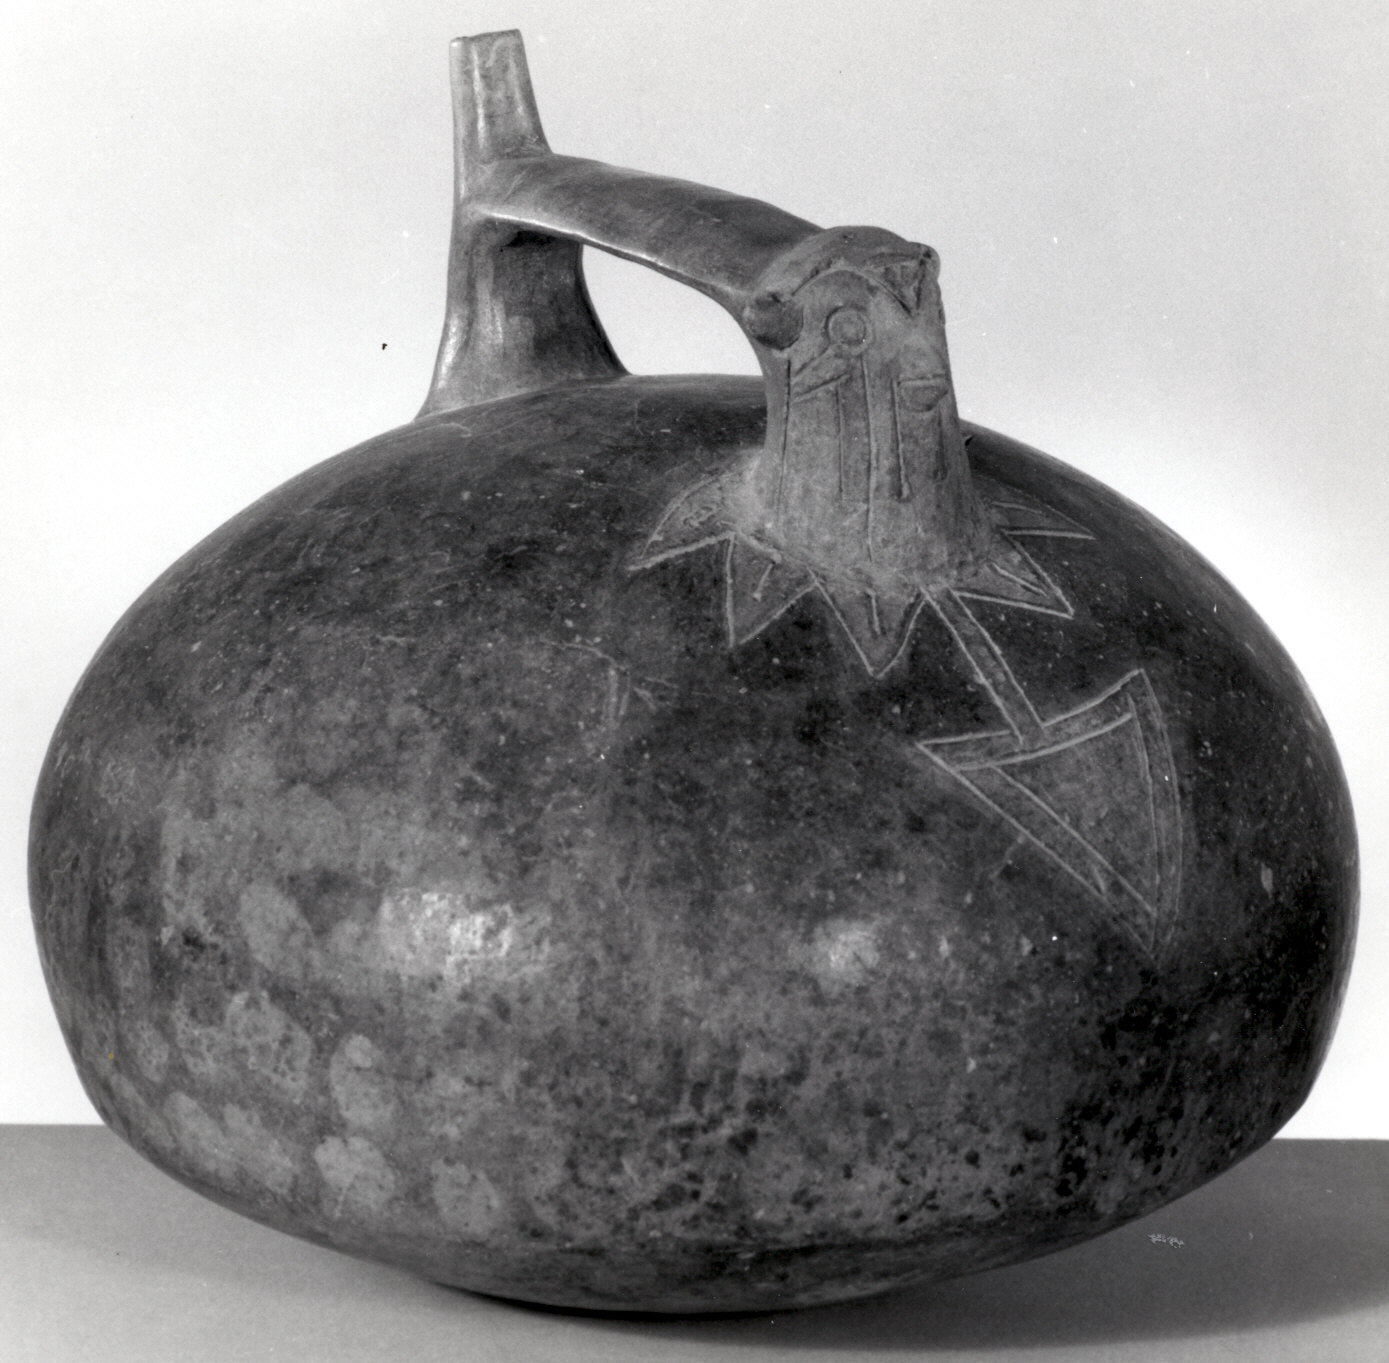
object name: bottle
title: Double Spout and Bridge Bottle with Bird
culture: paracas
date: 500-101 BCE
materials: ceramic, pigment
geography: peru